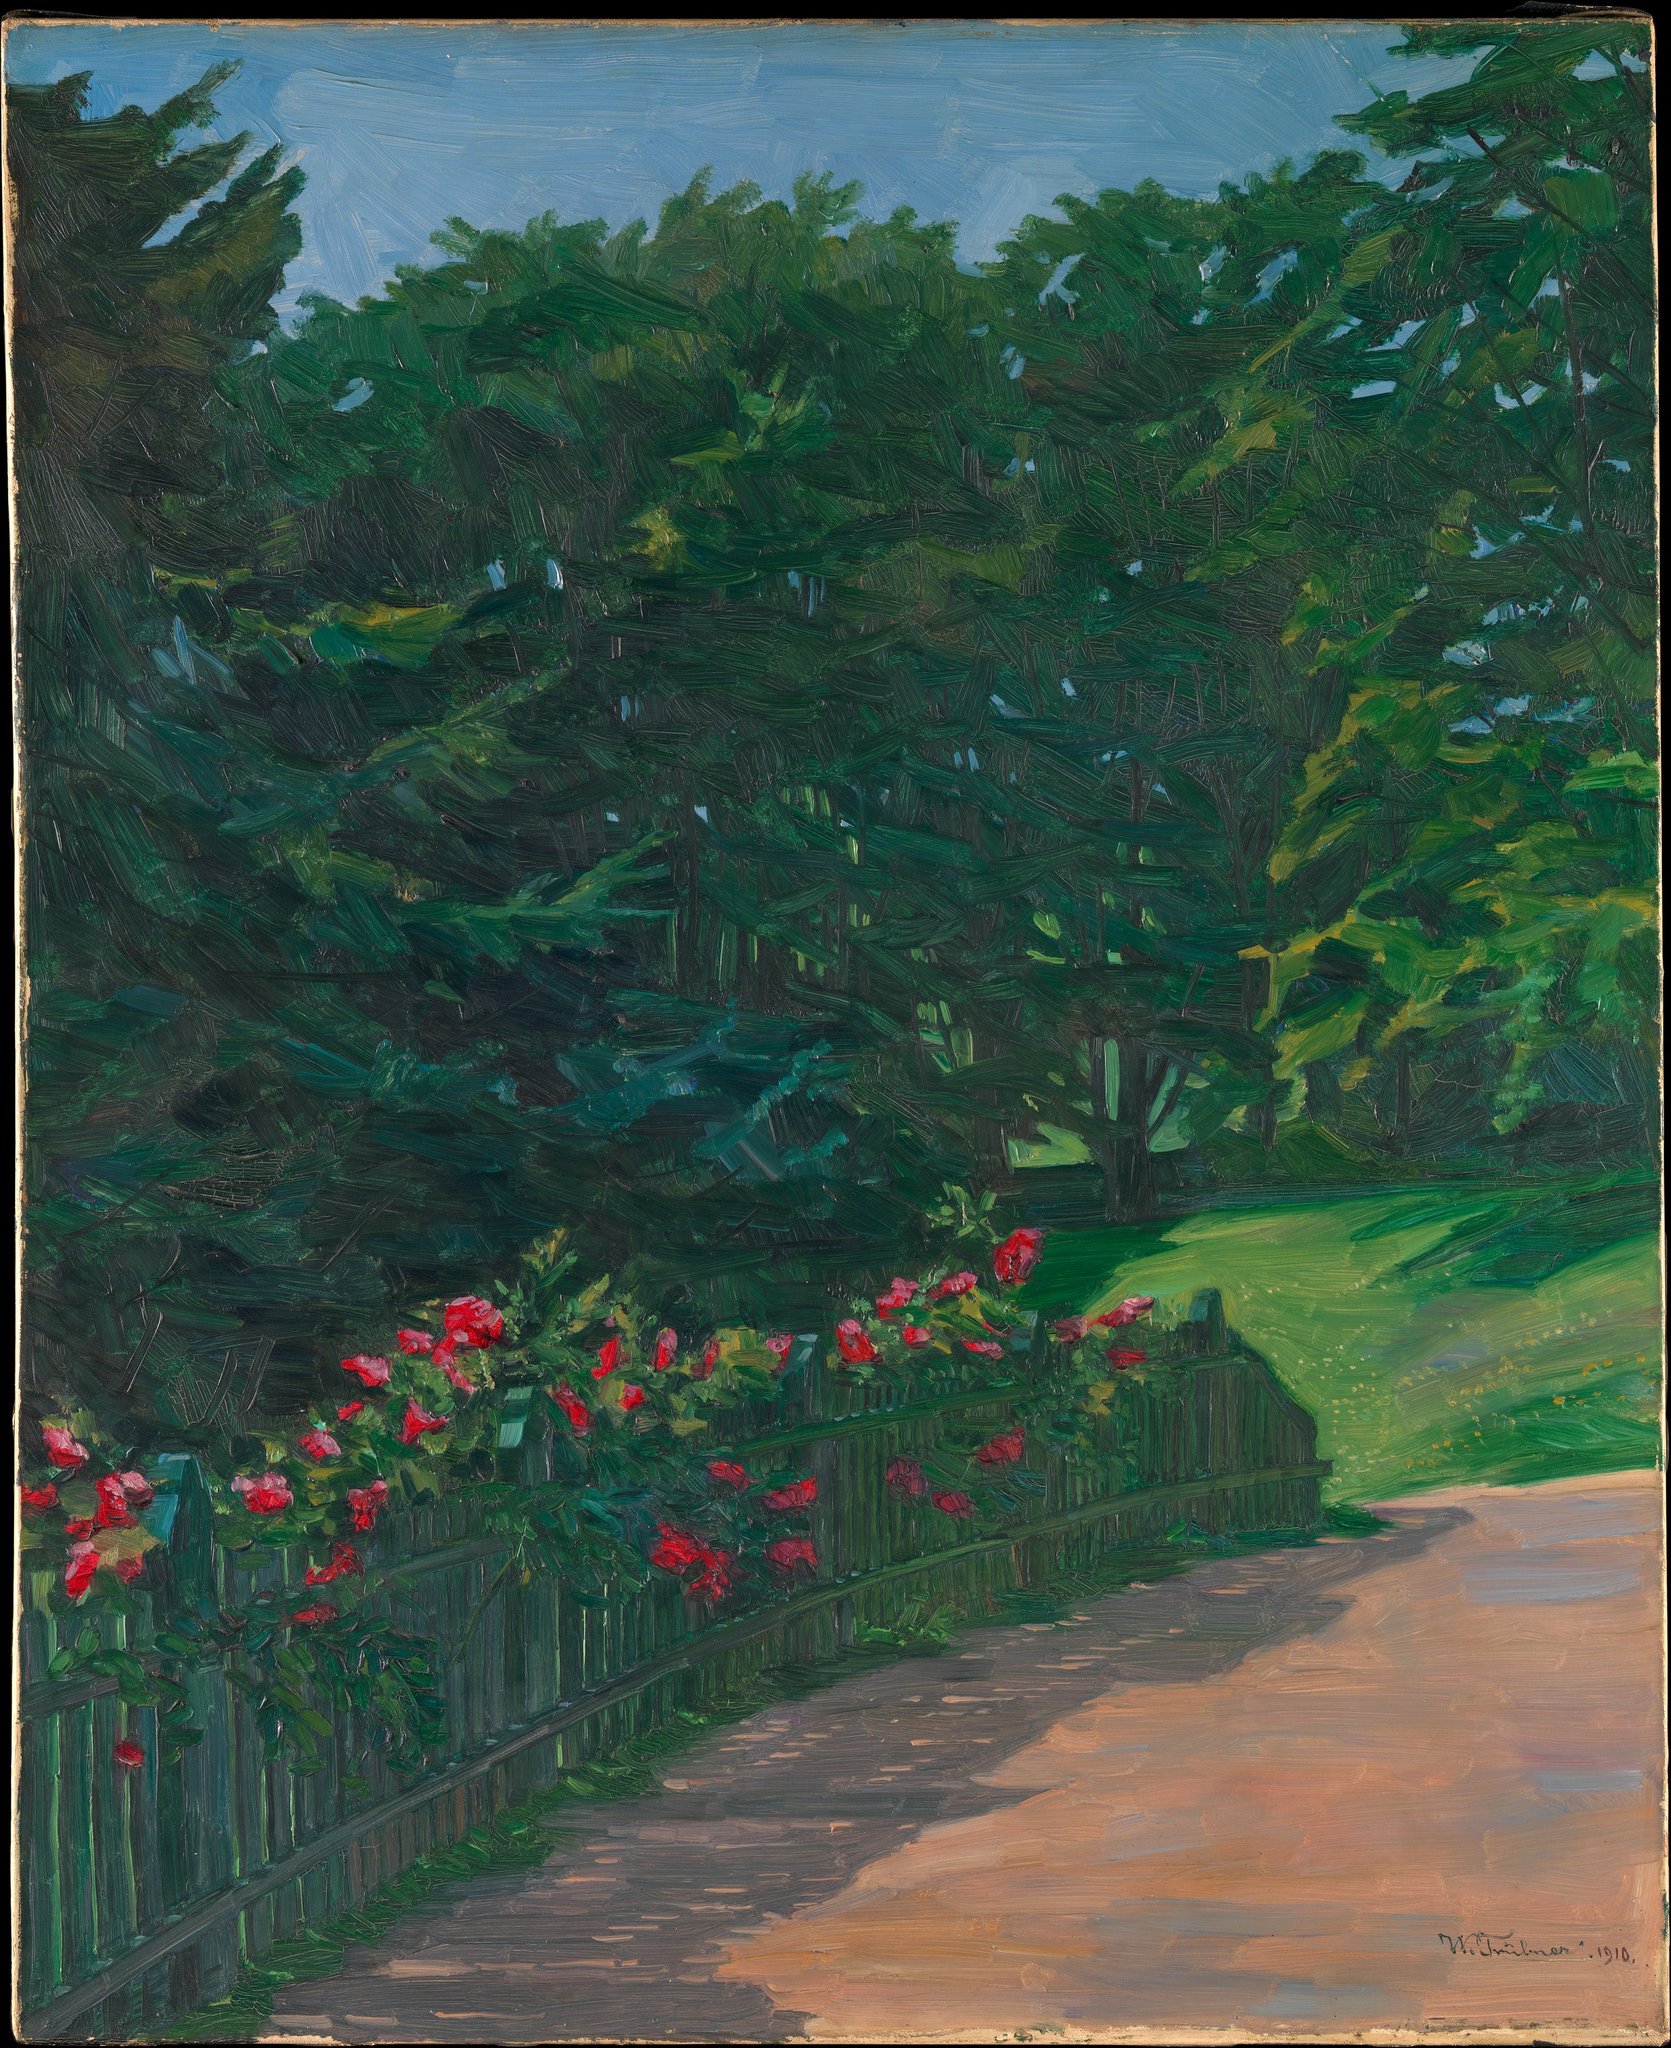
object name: painting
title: Rose Hedge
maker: wilhelm trübner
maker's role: artist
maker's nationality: german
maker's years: 1851-1917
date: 1910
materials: canvas, oil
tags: flowers,forests,landscapes